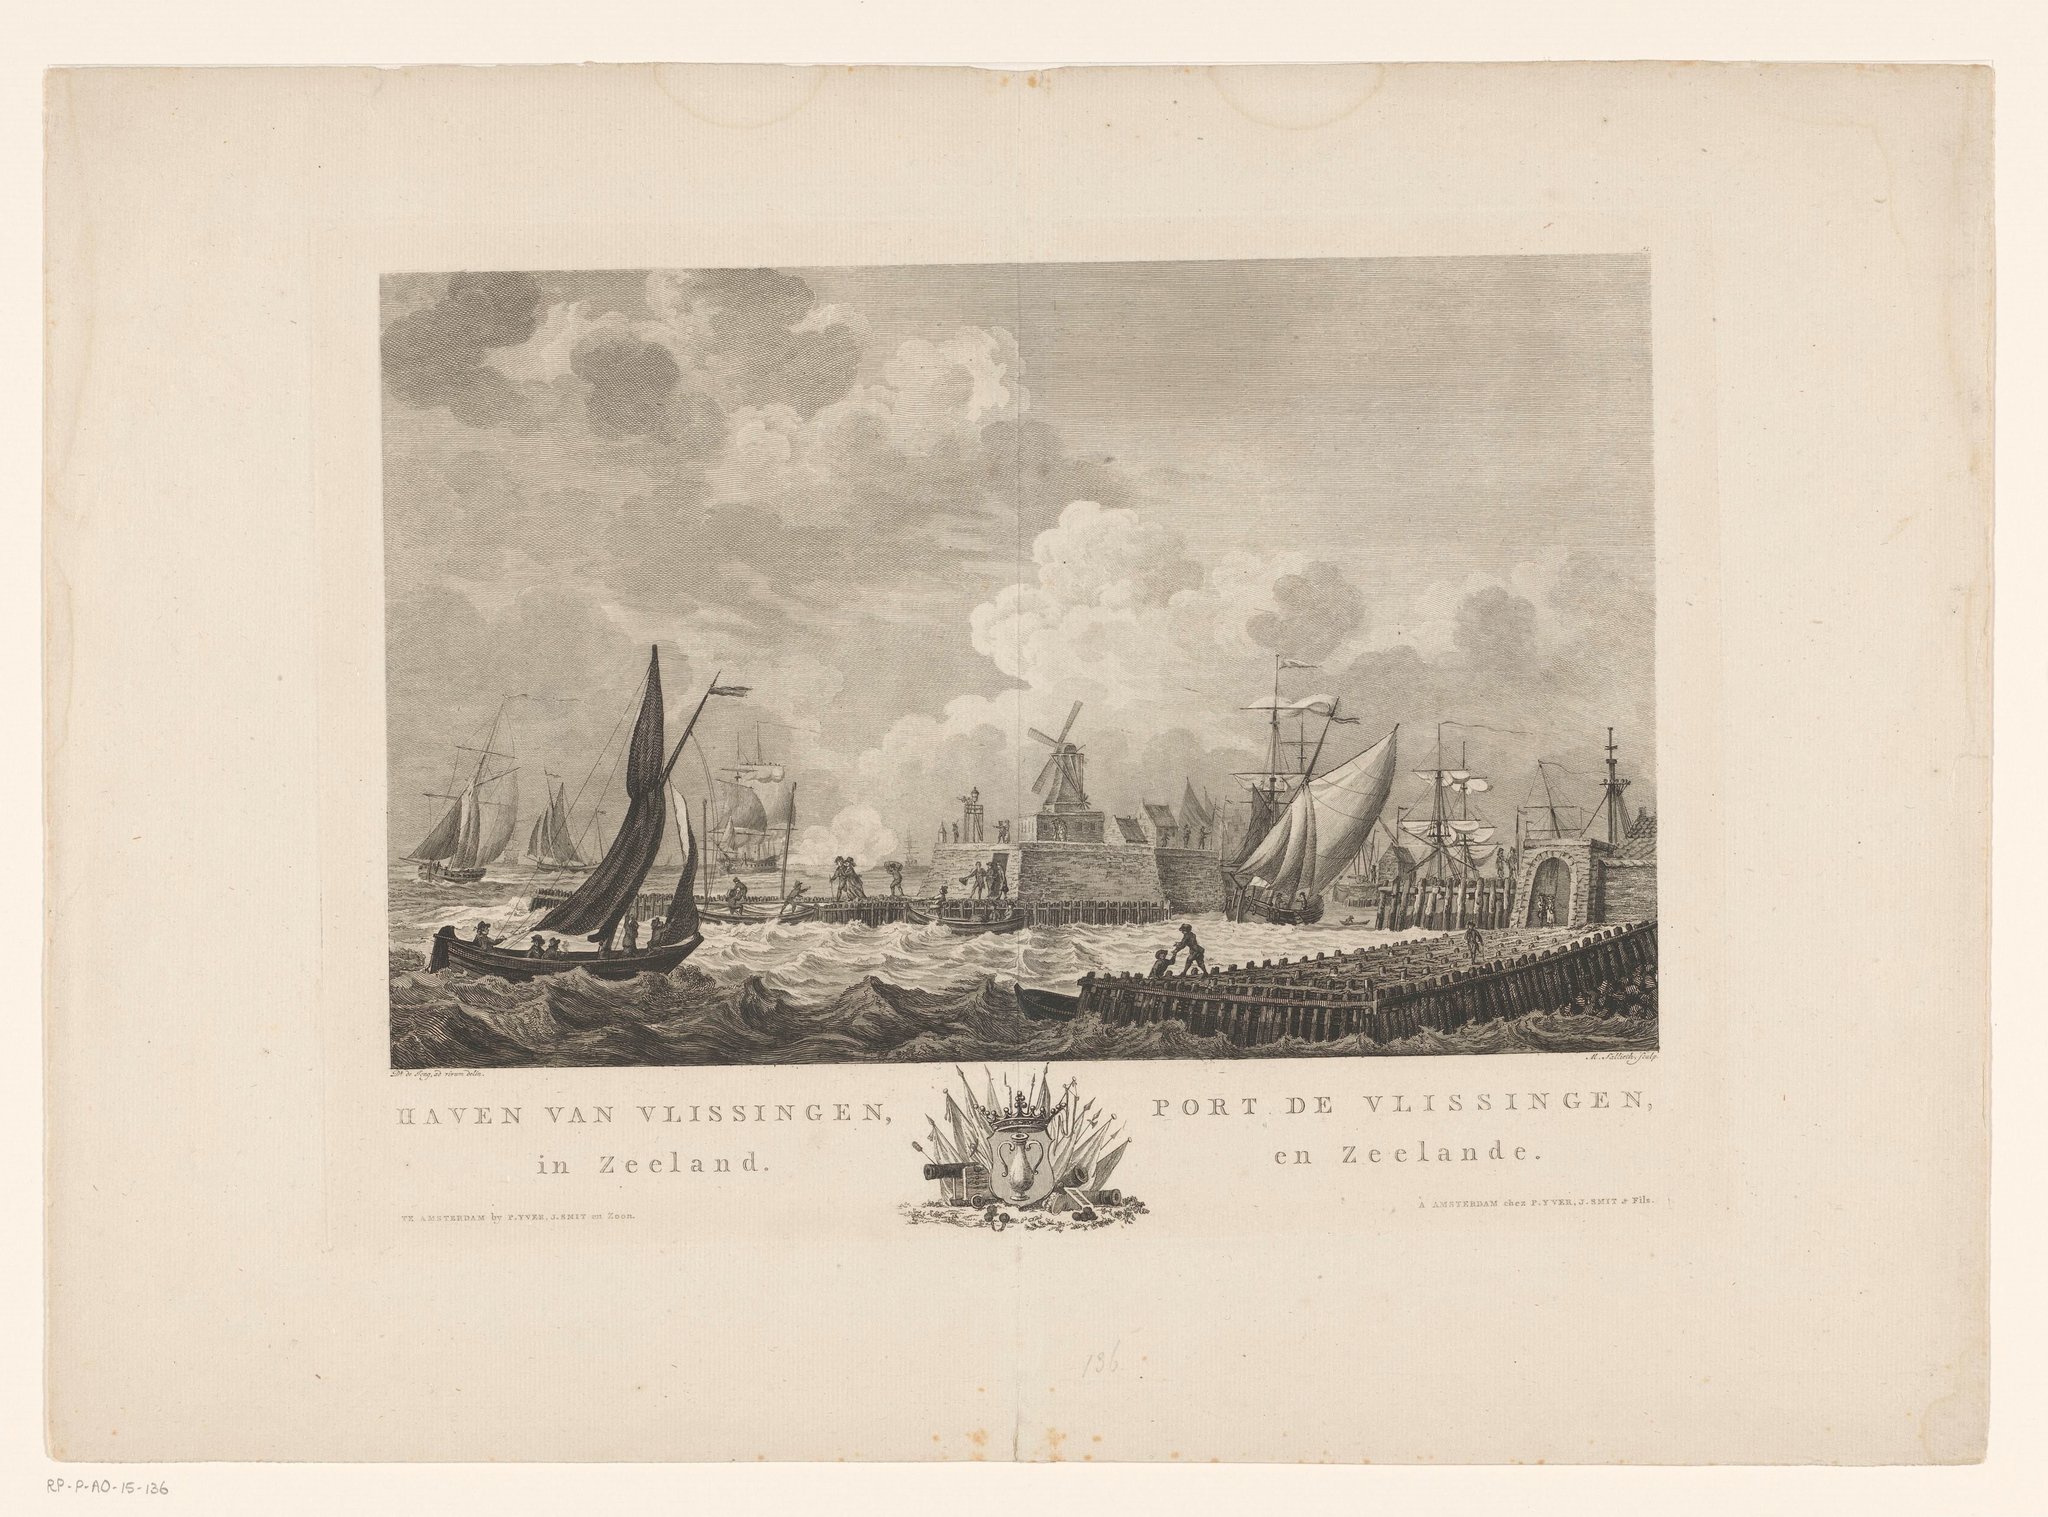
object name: print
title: Gezicht op de haven van Vlissingen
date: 1779-1787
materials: paper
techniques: engraving, etching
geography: amsterdam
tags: harbour, coat of arms (as symbol of the state, etc.) (+ city; municipal), sailing-ship, sailing-boat, flushing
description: Latere staat ook gebruikt in: Aa, Cornelis van der. Atlas van de zeehavens der Bataafsche Republiek. Met derzelver beschrijvingen in XXXI kunstplaaten / Atlas van de zeehavens der Bataafsche Republiek, die van Batavia en Onrust. Mitsgaders de afbeeldingen van de haringvisscherij en de walvischvangst (…). Amsterdam: Evert Maaskamp, 1805.